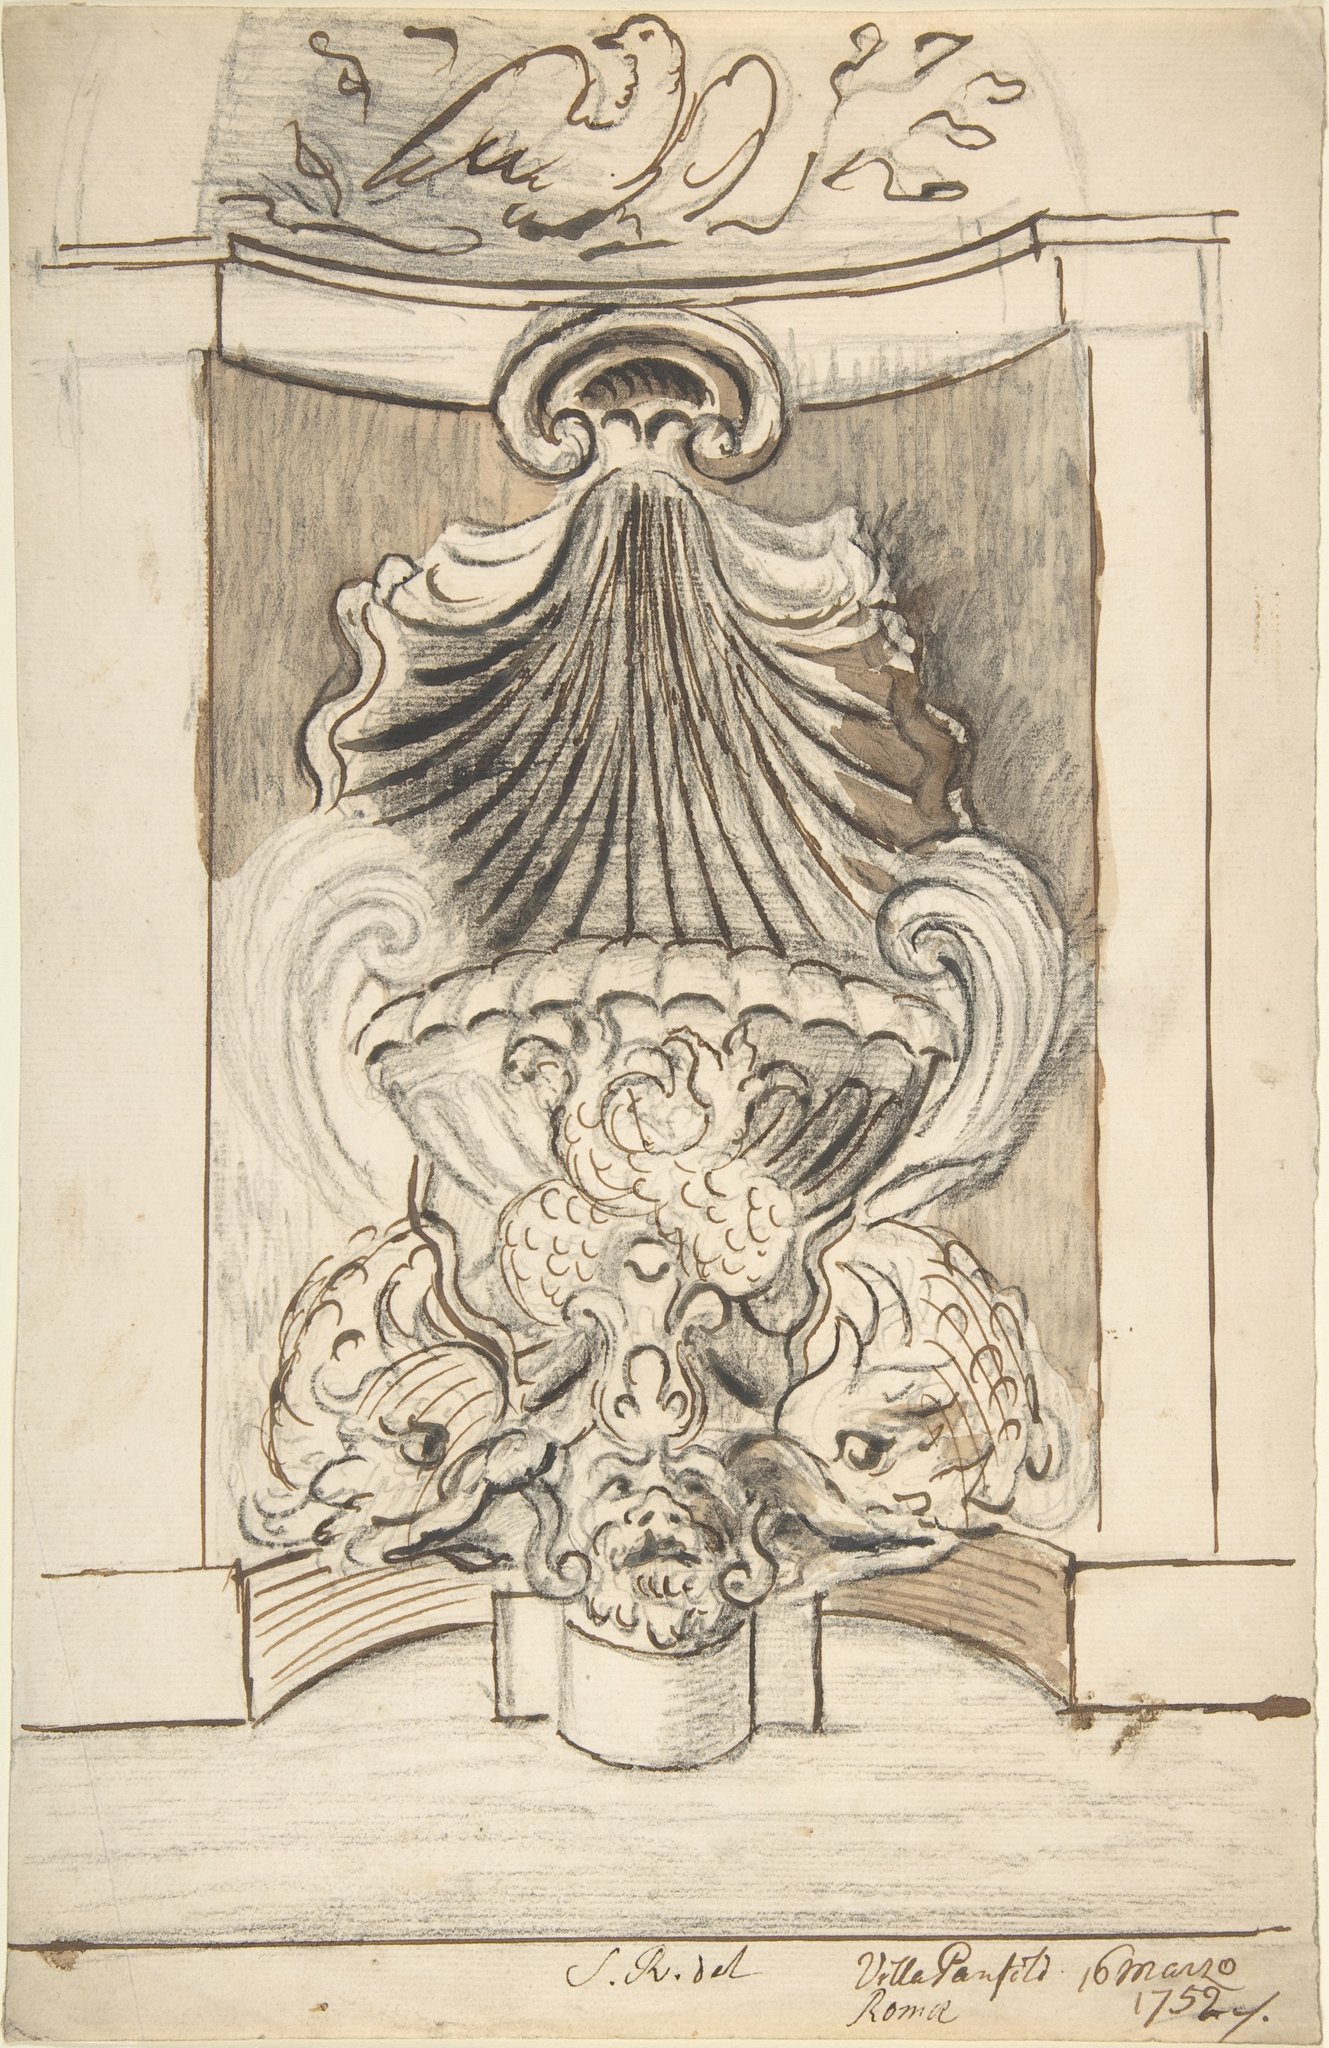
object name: drawing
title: Fountain at the Villa Panfili, Italy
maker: stephen riou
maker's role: artist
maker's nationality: british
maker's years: 1720-1780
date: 1752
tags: birds,fountains,fish